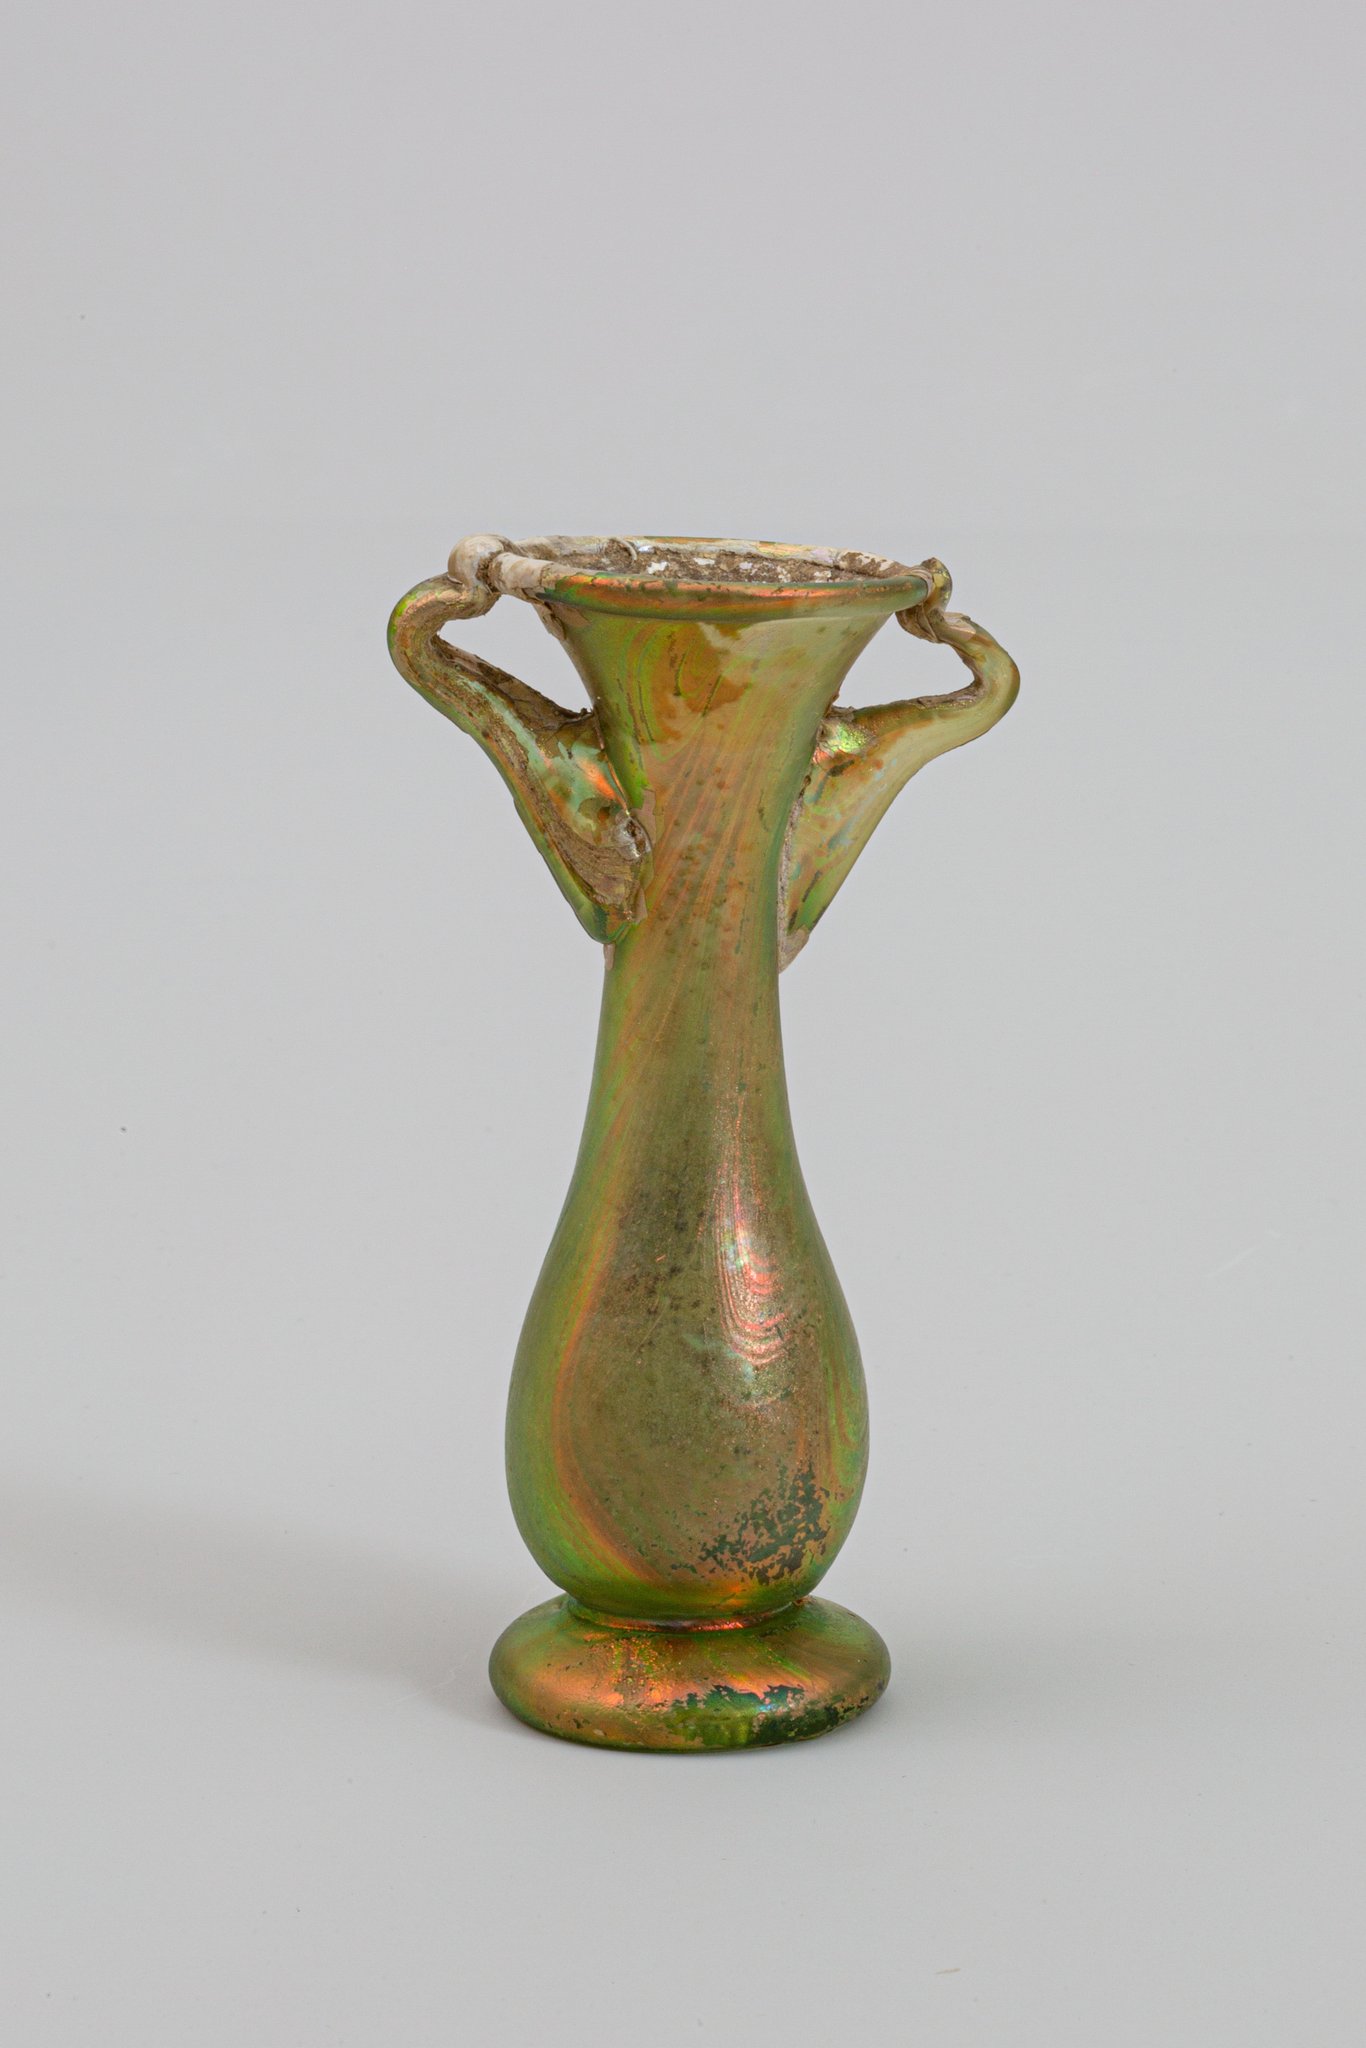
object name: cosmetic flask, single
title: Glass cosmetic flask (kohl tube)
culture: roman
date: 301-400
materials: glass